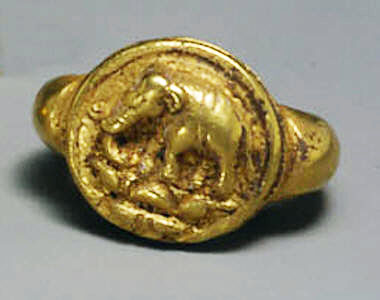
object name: ring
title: Ring with Oval Bezel with an Elephant on a Lotus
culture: indonesian, javanese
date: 701-933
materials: gold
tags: elephants